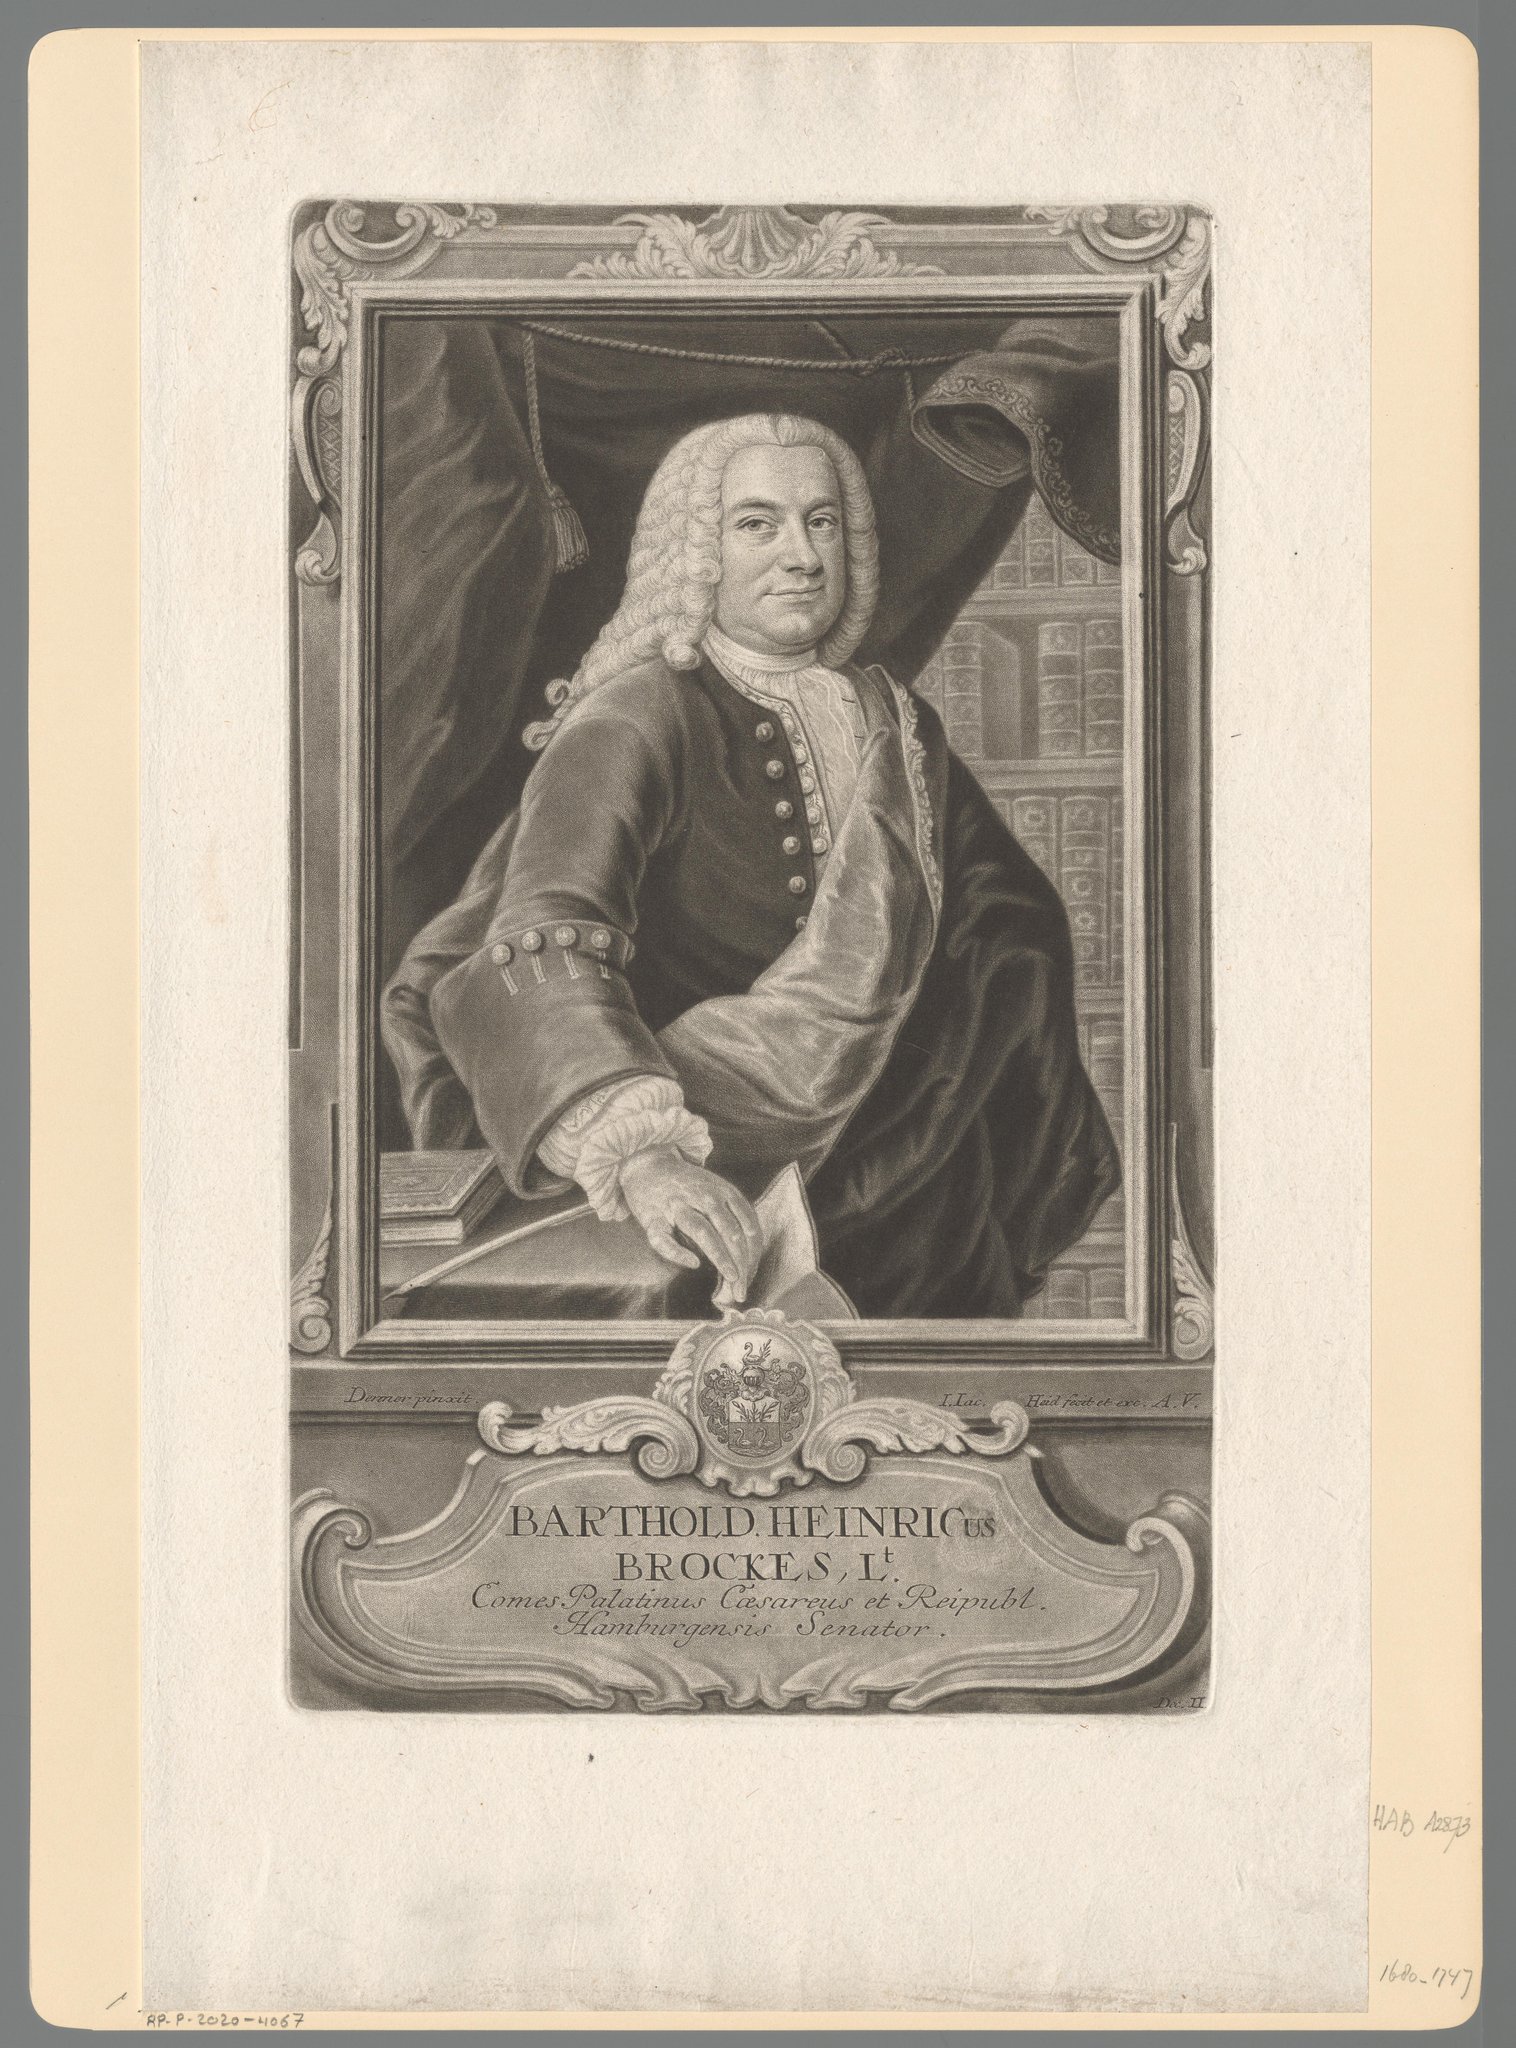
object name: print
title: Portret van Barthold Hinrich Brockes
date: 1714-1767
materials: paper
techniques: engraving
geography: augsburg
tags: barthold hinrich brockes, bookshelves, historical persons, book, writer, poet, author, armorial bearing, heraldry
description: Prent mogelijk uit: Brucker, Johann Jakob. Bilder-sal heutiges Tages lebender und durch Gelahrheit berühmter Schrifft-steller (...). Augsburg: Johann Jacob Haid, 1742, dl. 2.